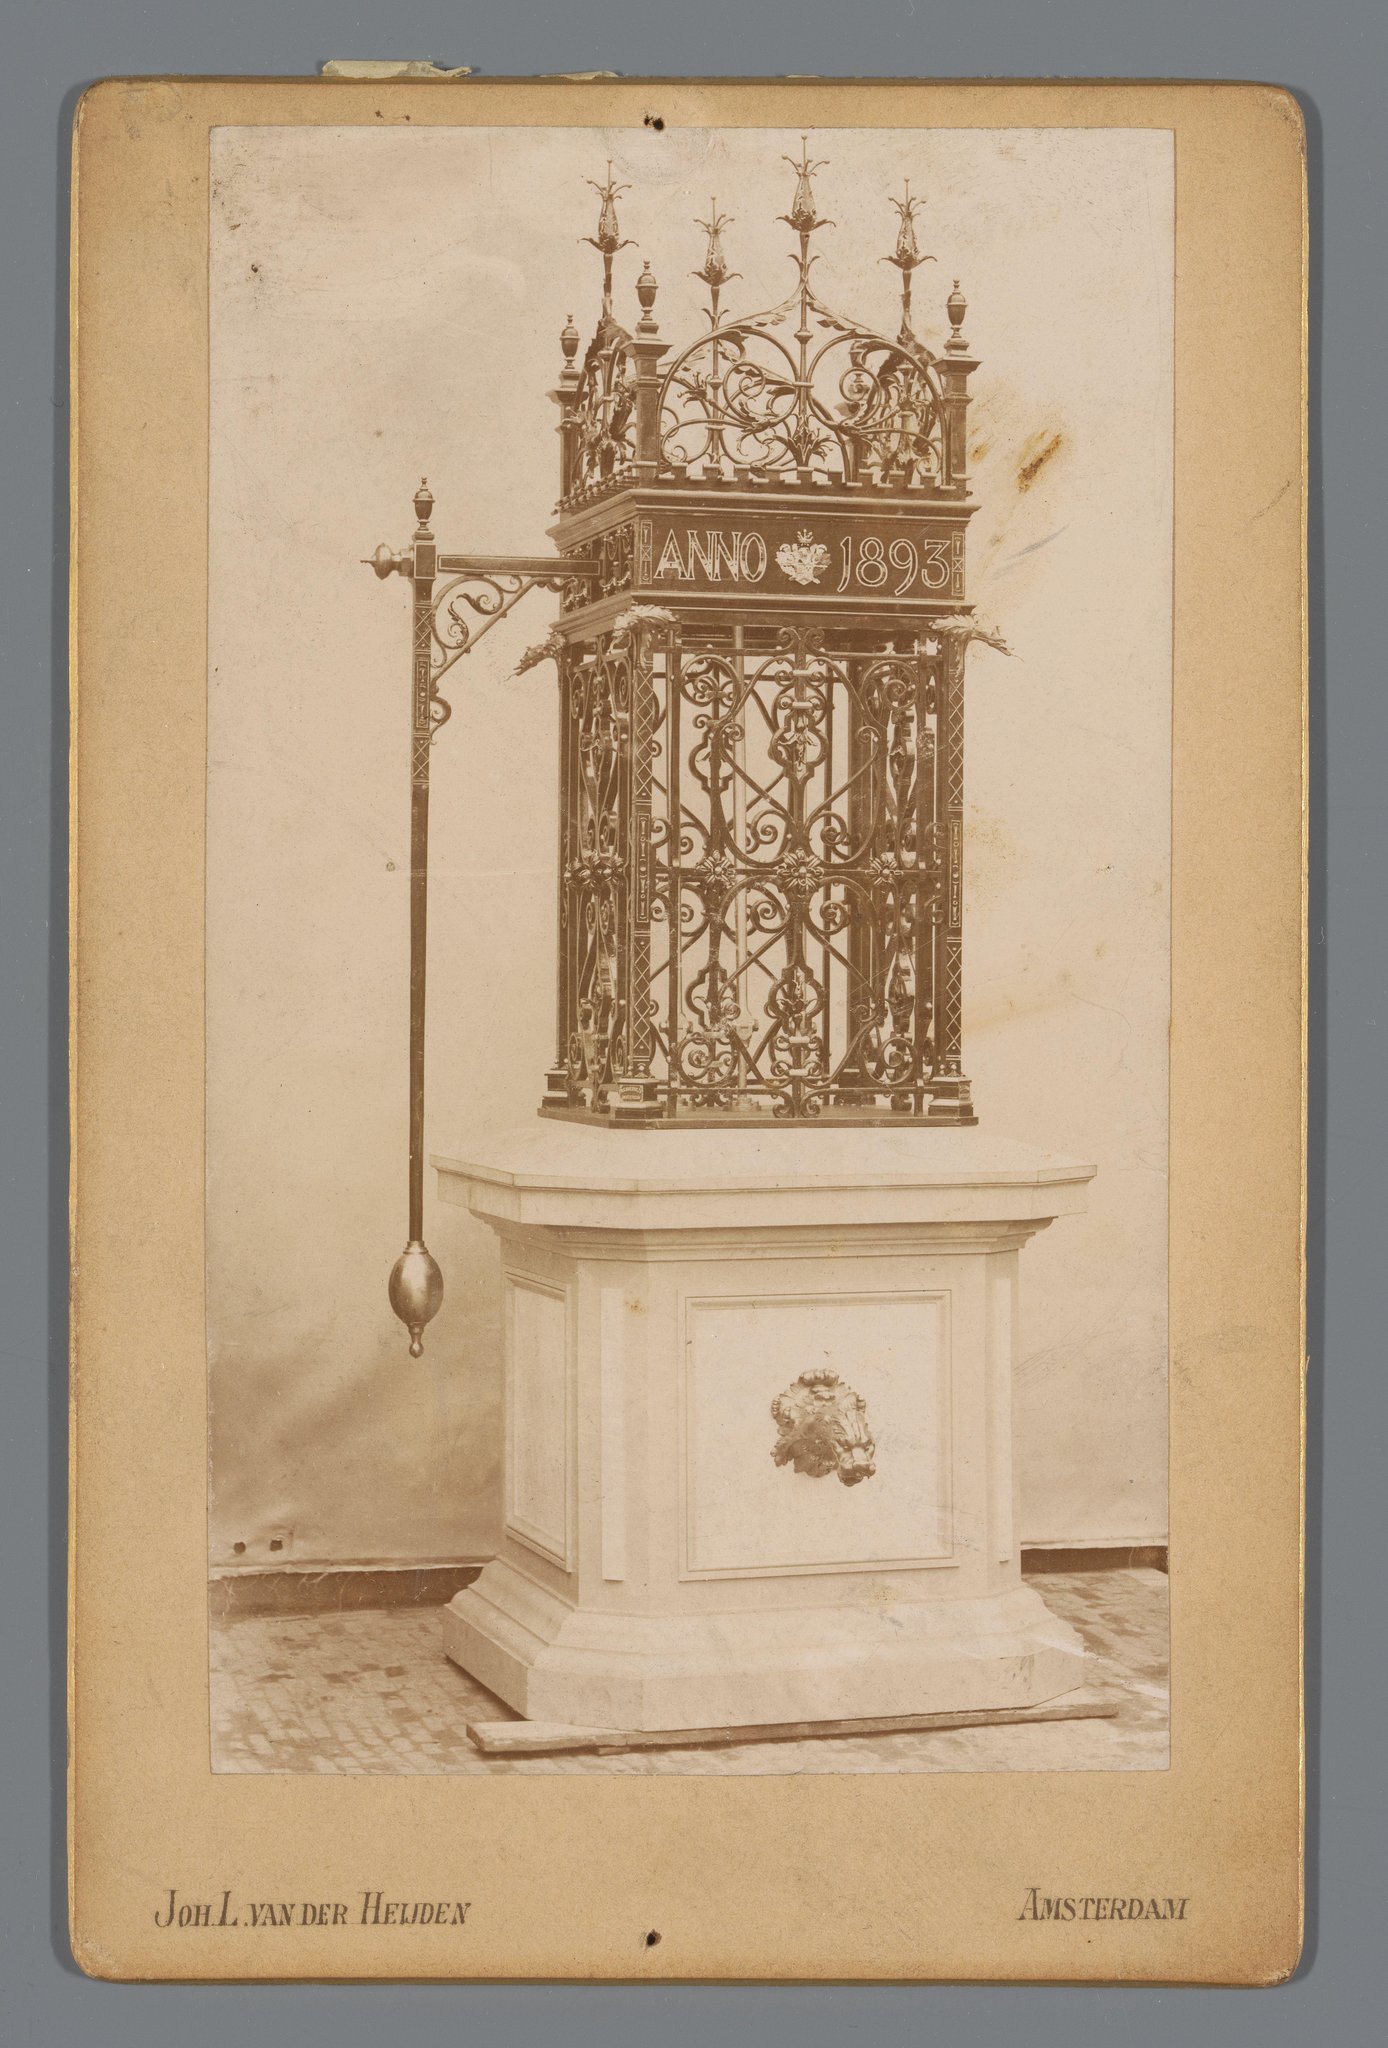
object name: cabinet photograph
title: Nortonpomp te Nigtevecht, met op achterzijde menu van het diner bij de onthulling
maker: johannes leonardus van der heijden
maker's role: fotograaf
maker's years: 1856-1937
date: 1894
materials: paper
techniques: letterpress printing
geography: nigtevecht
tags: pump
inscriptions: inscription: ‘Joh. L. van der Heijden Amsterdam’, inscription: ‘Inauguration de la pompe Norton/ à Nichtevecht/ 15 Juin 1894./ Déjeûner dinatoire/ Menu (...)’